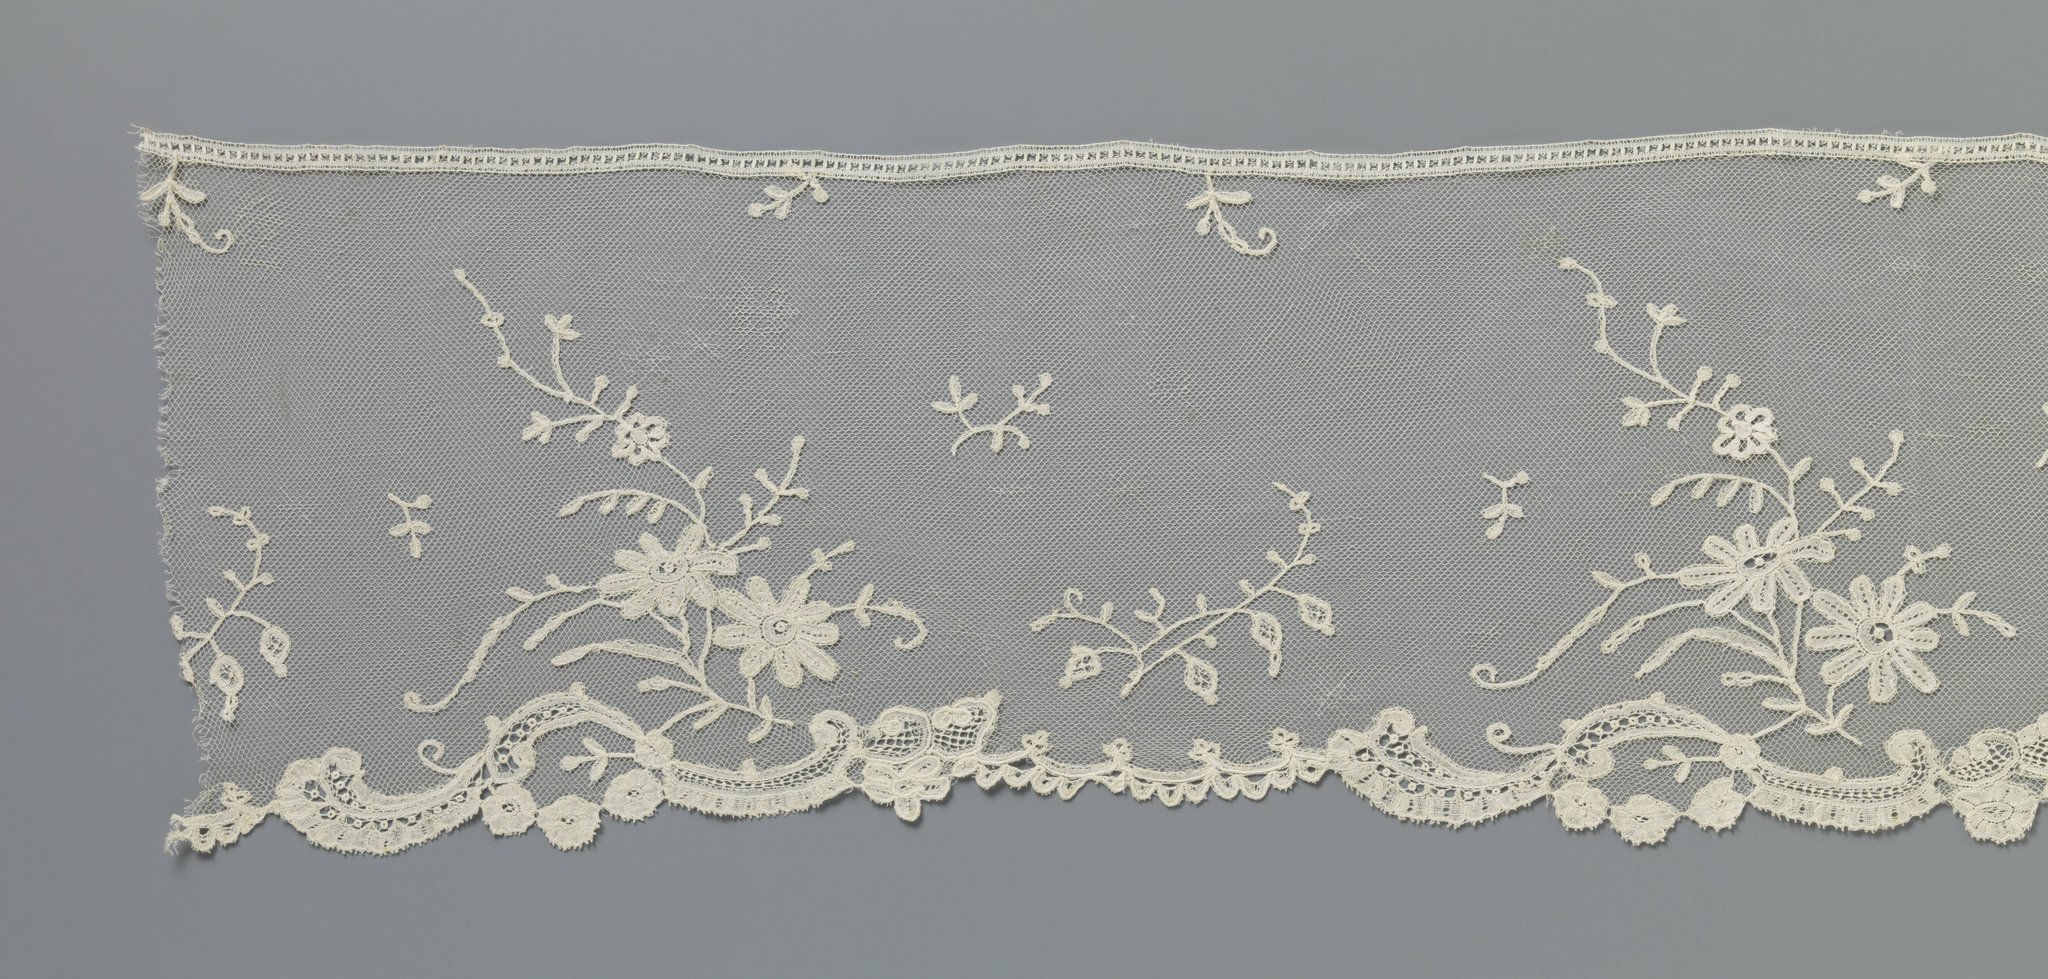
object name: strip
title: Strook applicatiekant met margrietentakken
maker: Anonymous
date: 1890-1899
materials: linen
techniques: lace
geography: brussels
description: Strook naturelkleurige applicatiekant, kloskant geappliceerd op machinale tule. Op een met takjes versierd fond staan, langs de geschulpte kant, afwisselend een grote tak met margrieten en een kleine tak met klokjesbloemen. De gestrekte schulpen vertonen onder andere gebroken c-voluten en met rasterwerk gevulde rocailles.